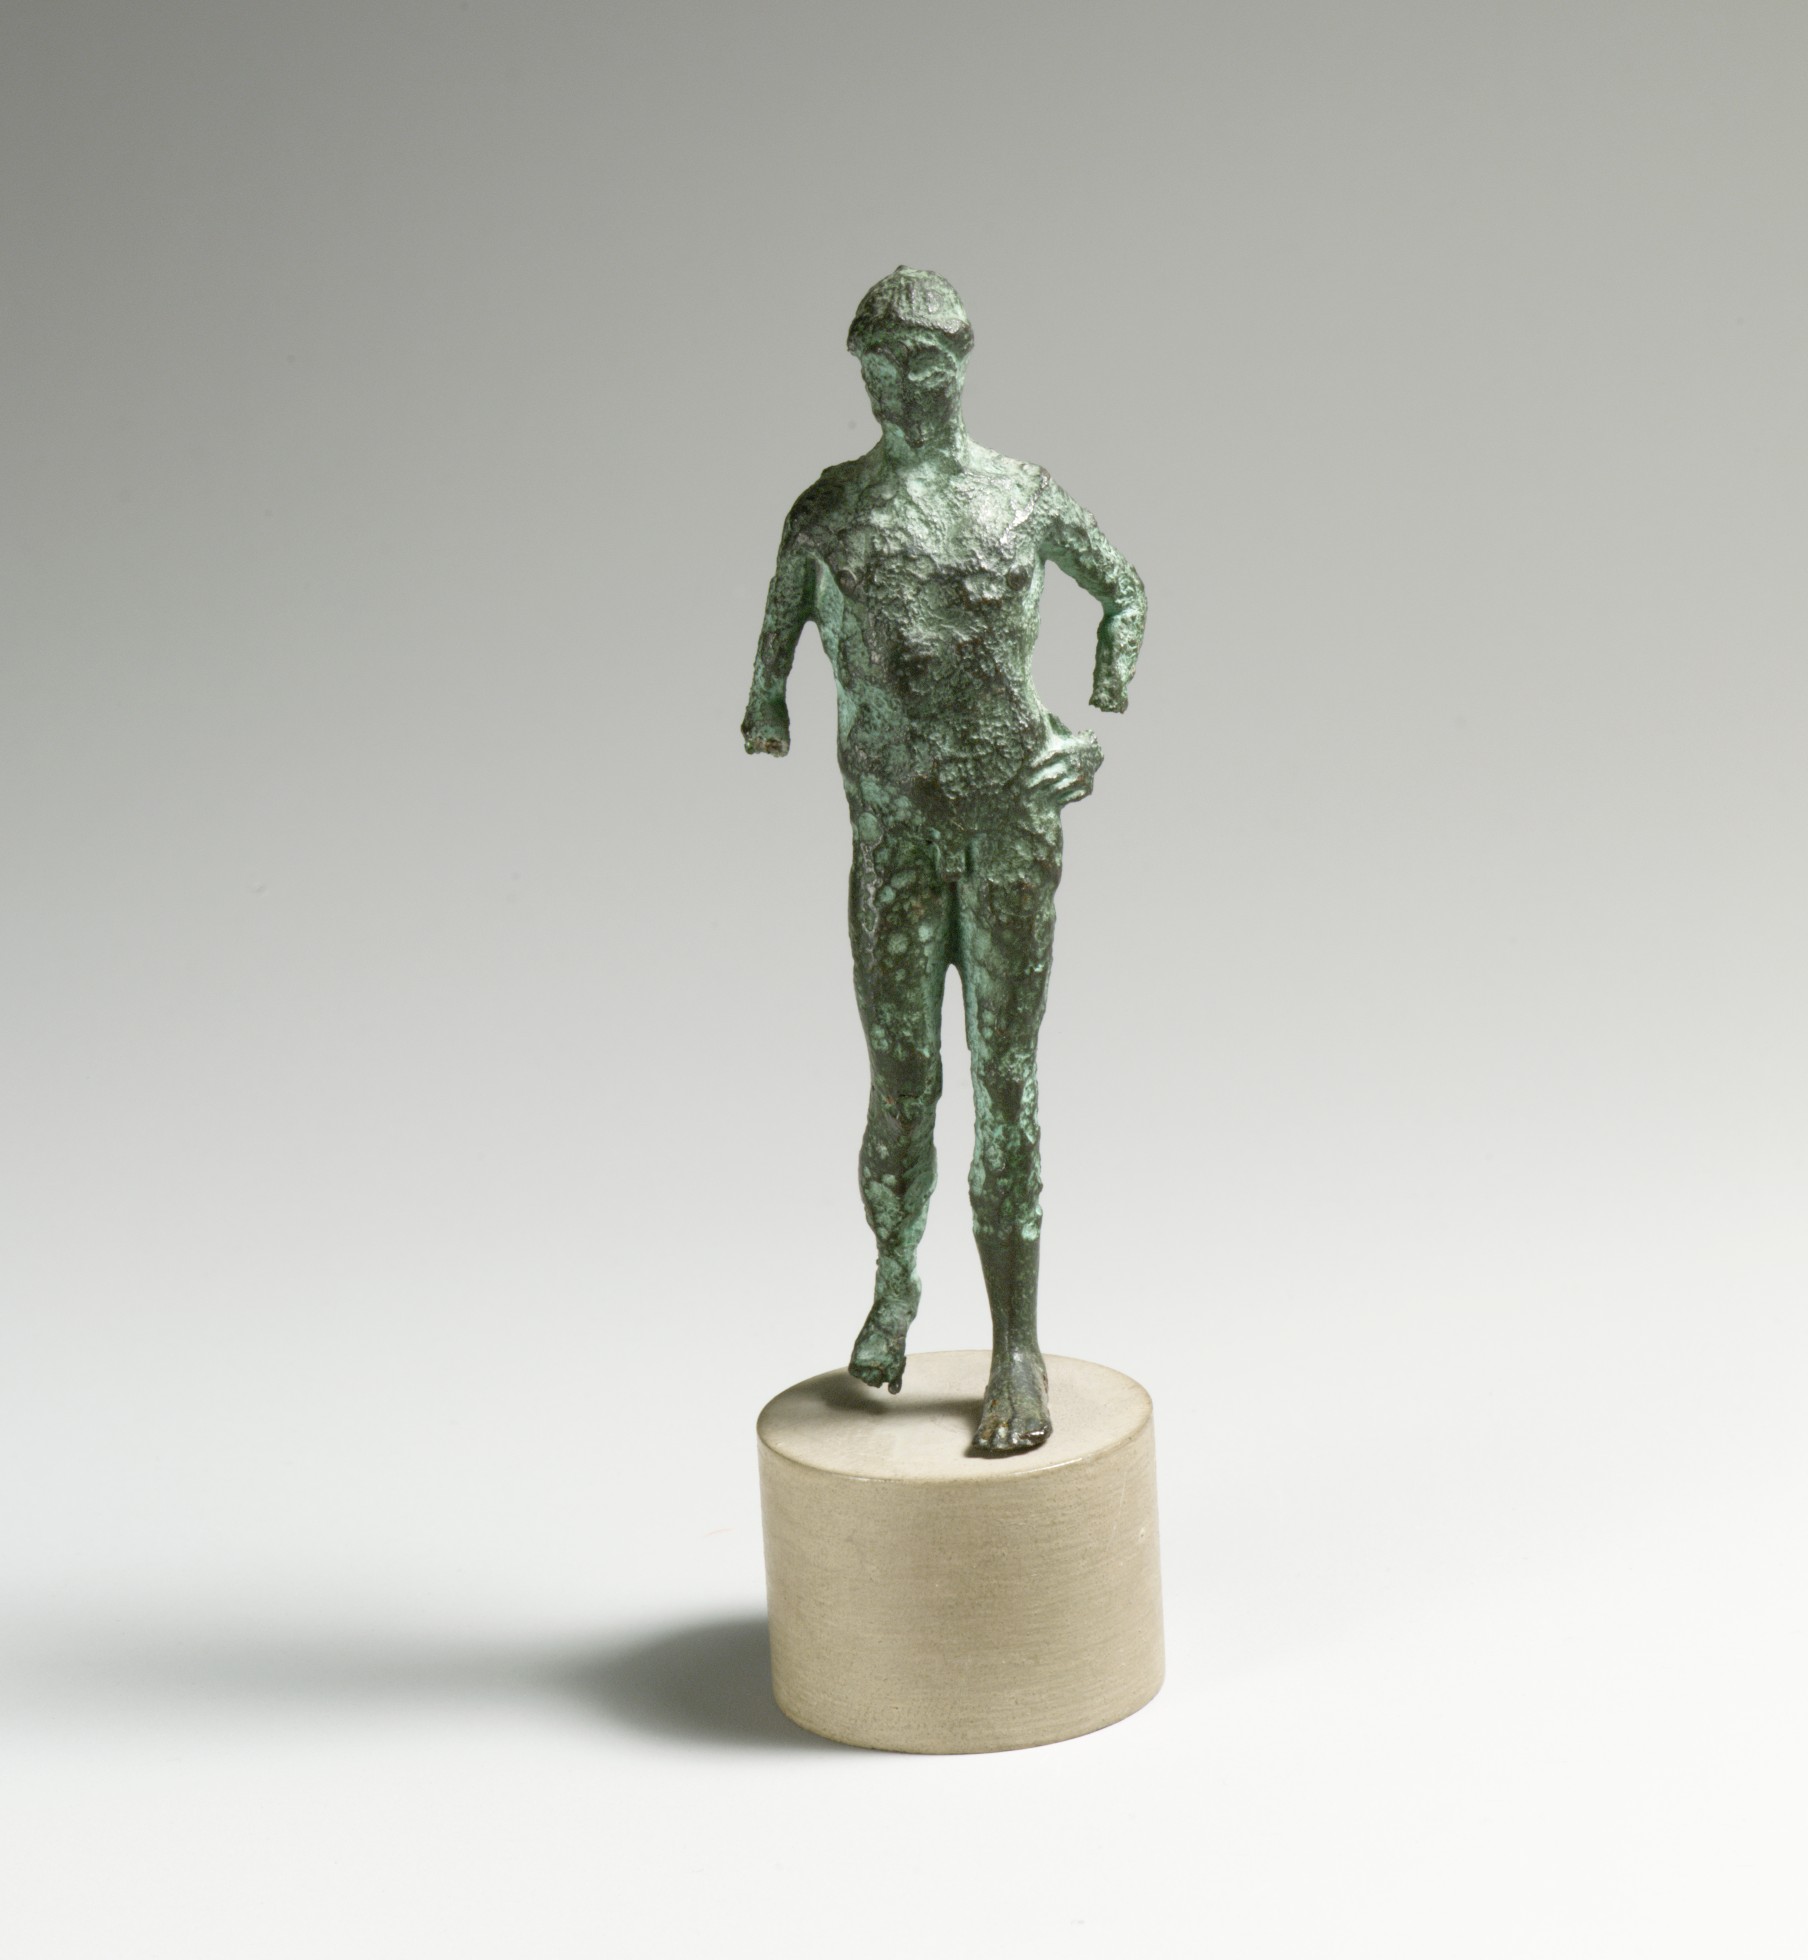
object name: statuette of a youth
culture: greek, cypriot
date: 400-301 BCE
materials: bronze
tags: men